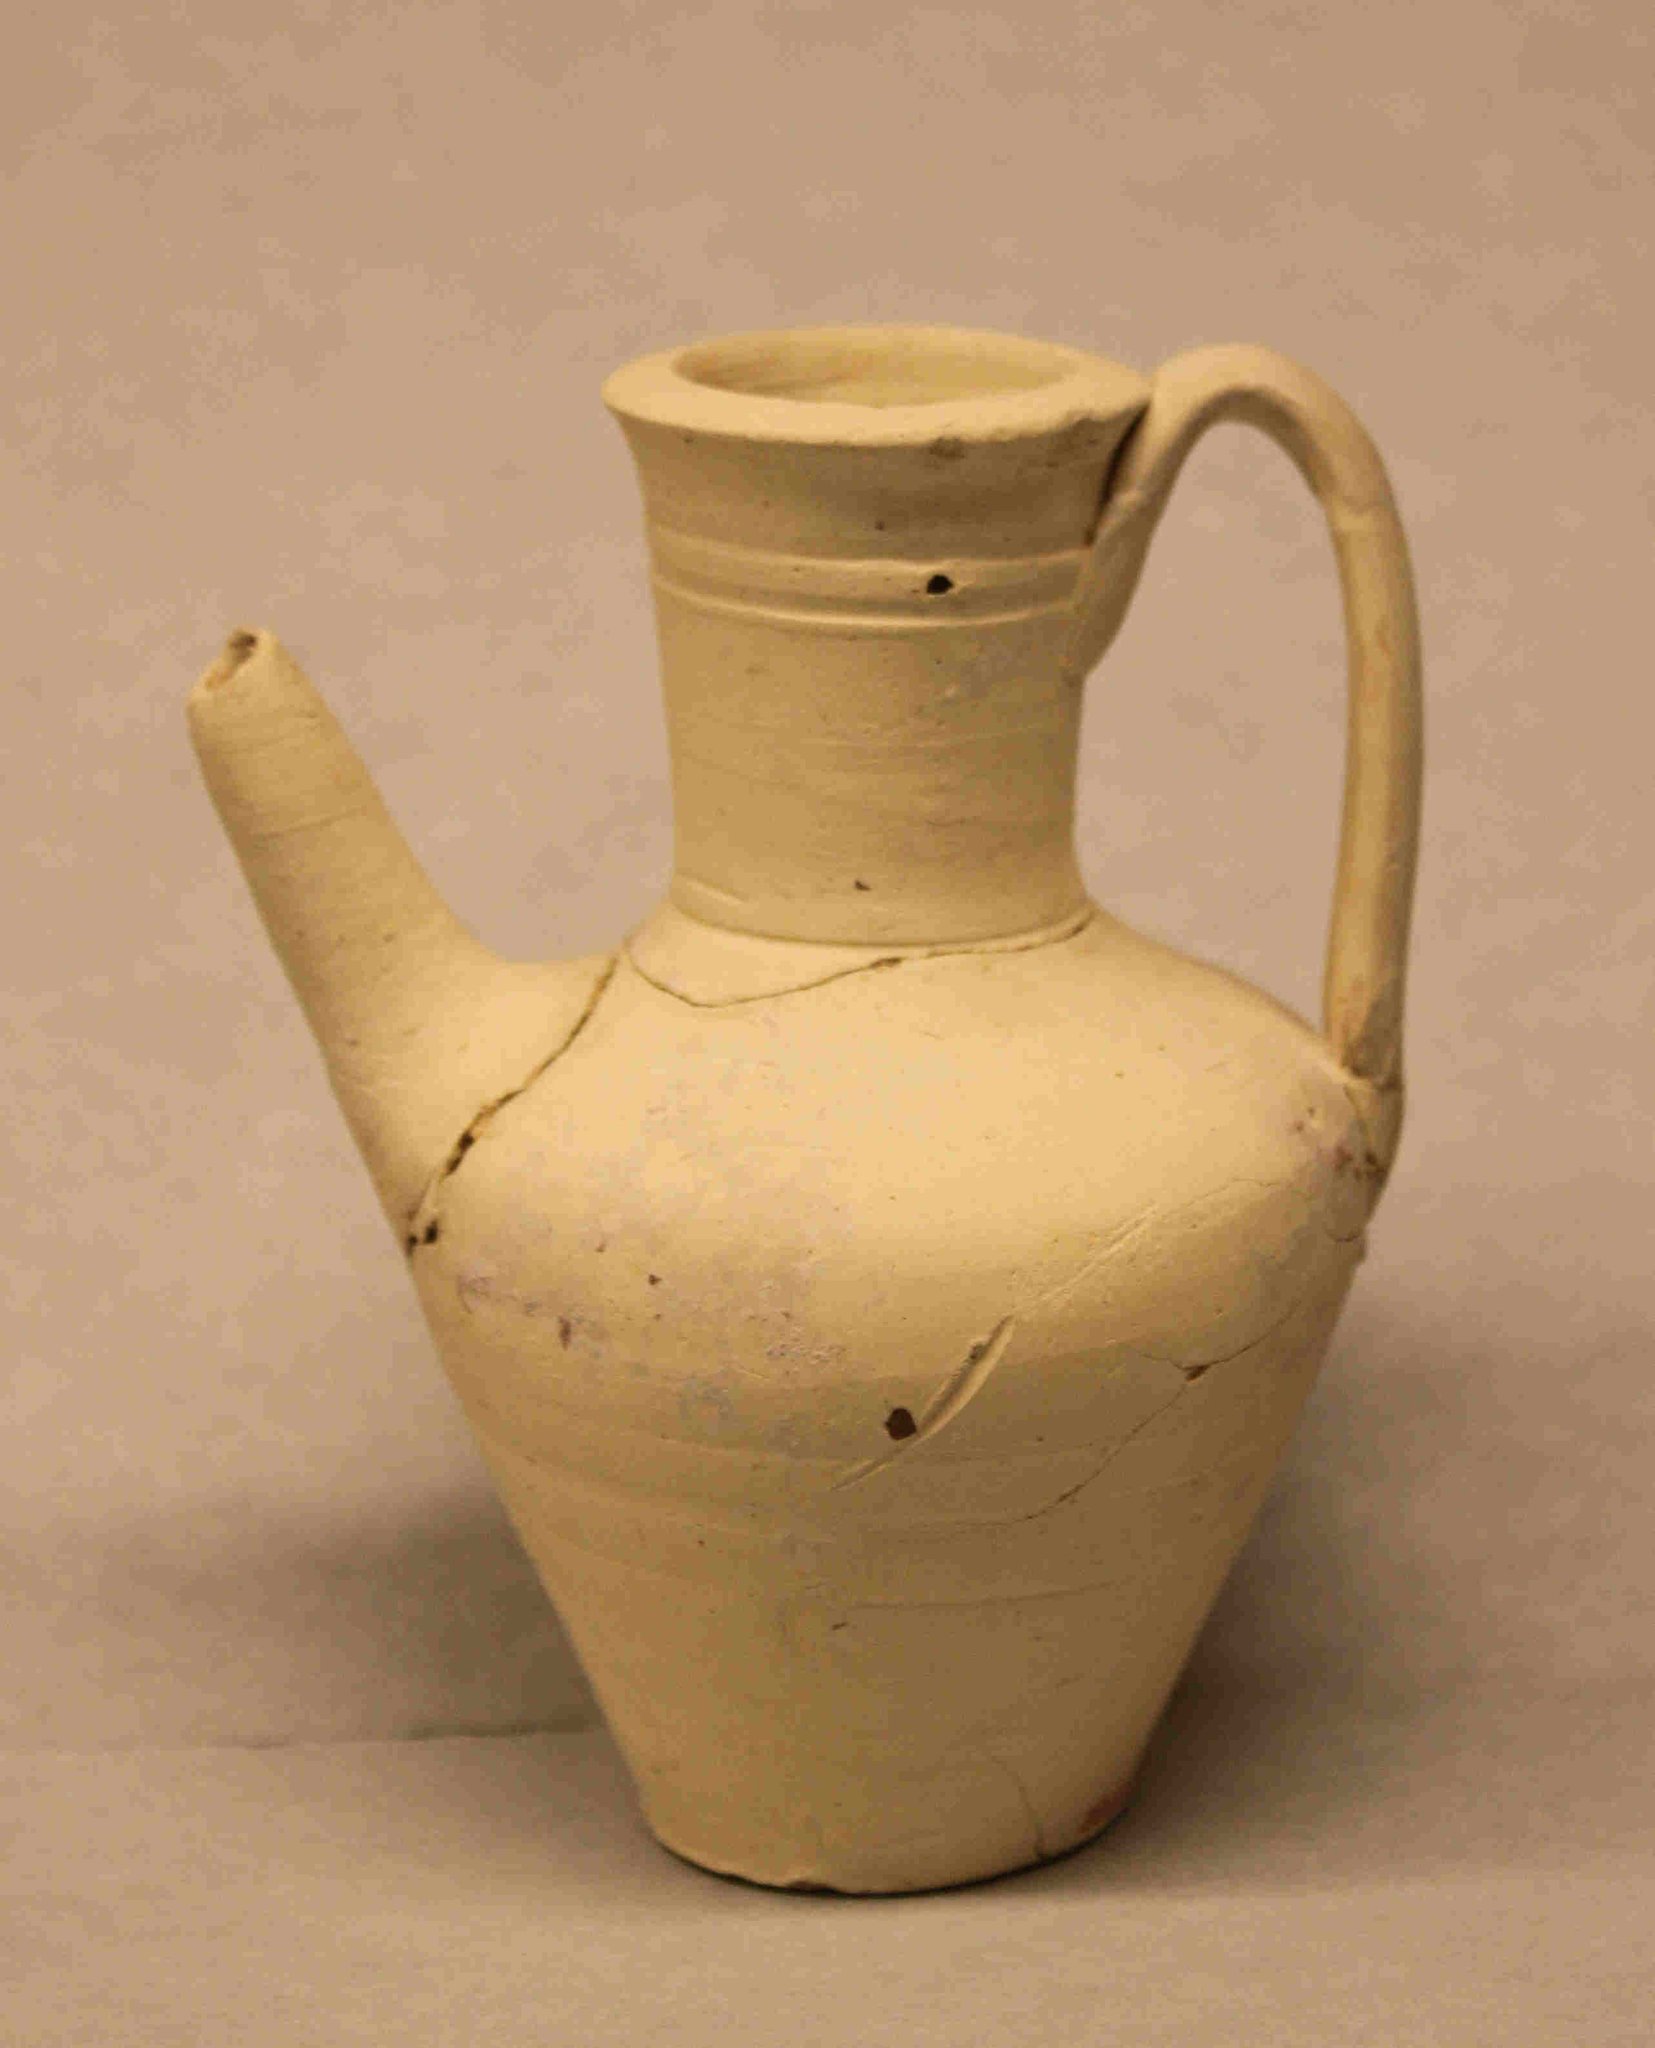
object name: ewer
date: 801-900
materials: earthenware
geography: iran